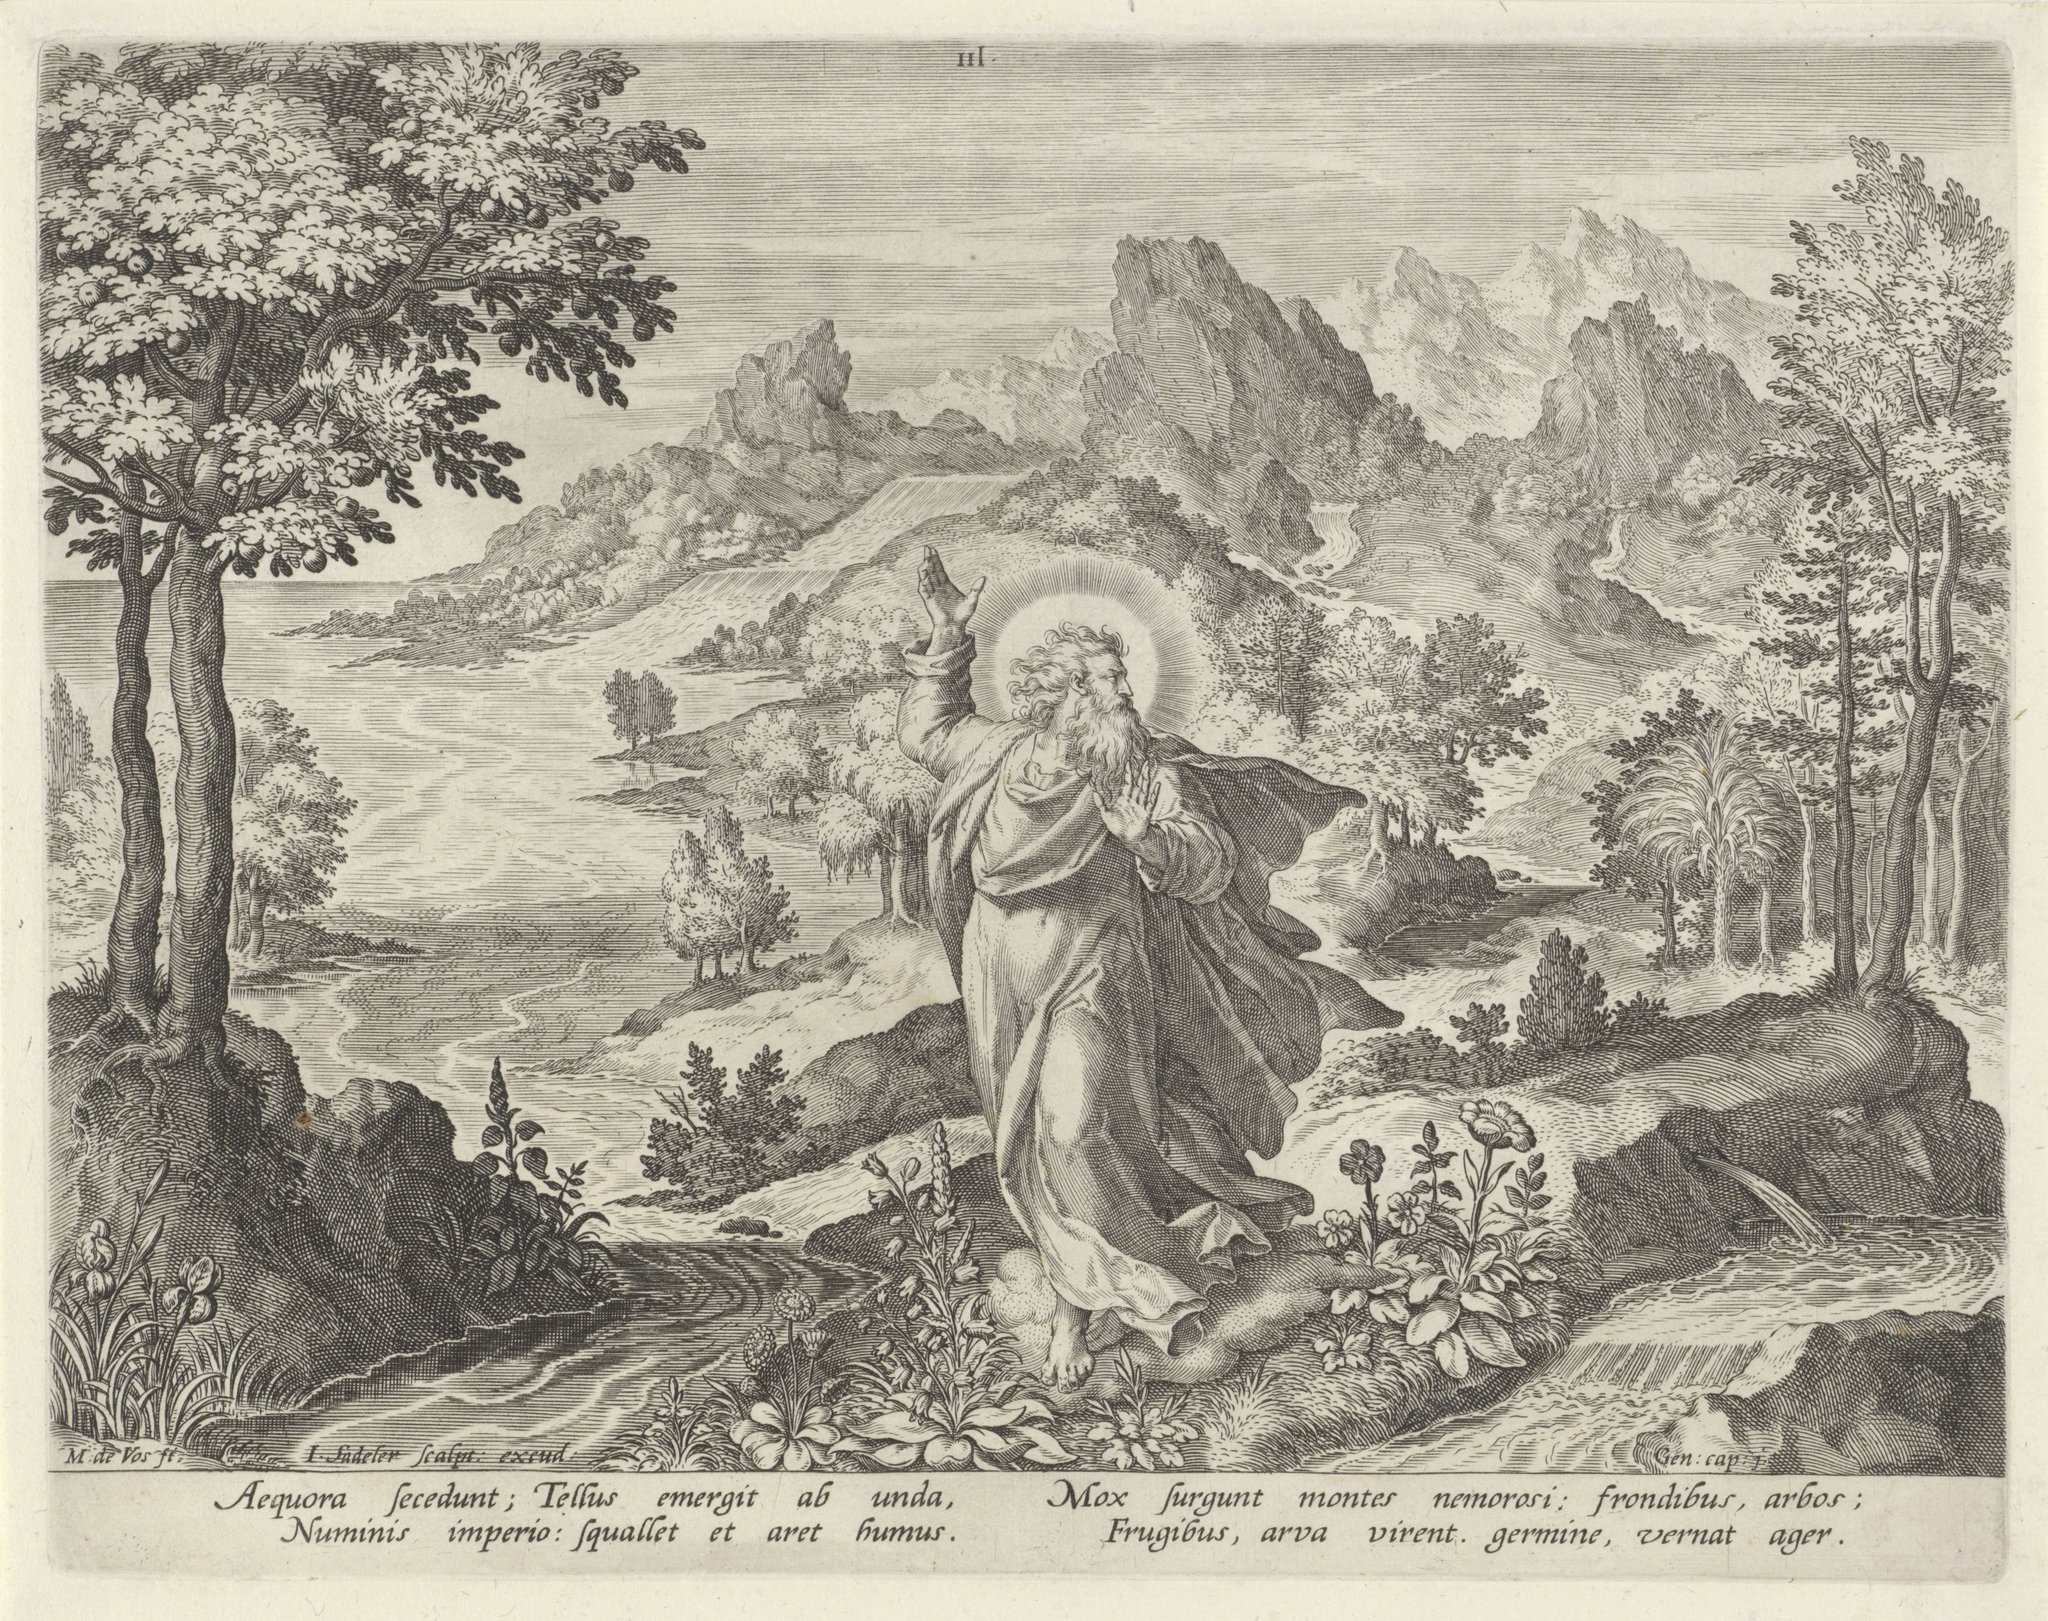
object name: print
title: Schepping van de wereld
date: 1588-1600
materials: paper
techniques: engraving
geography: munich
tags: god the creator, gathering of the waters below the firmament; dry land appears and produces all kinds of plants, coast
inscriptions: collector's mark: Lugt 240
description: Een kustlandschap met centraal God de Vader. Op de derde dag van de schepping schiep God de aarde, de zee en de planten. De prent heeft een Latijns onderschrift.